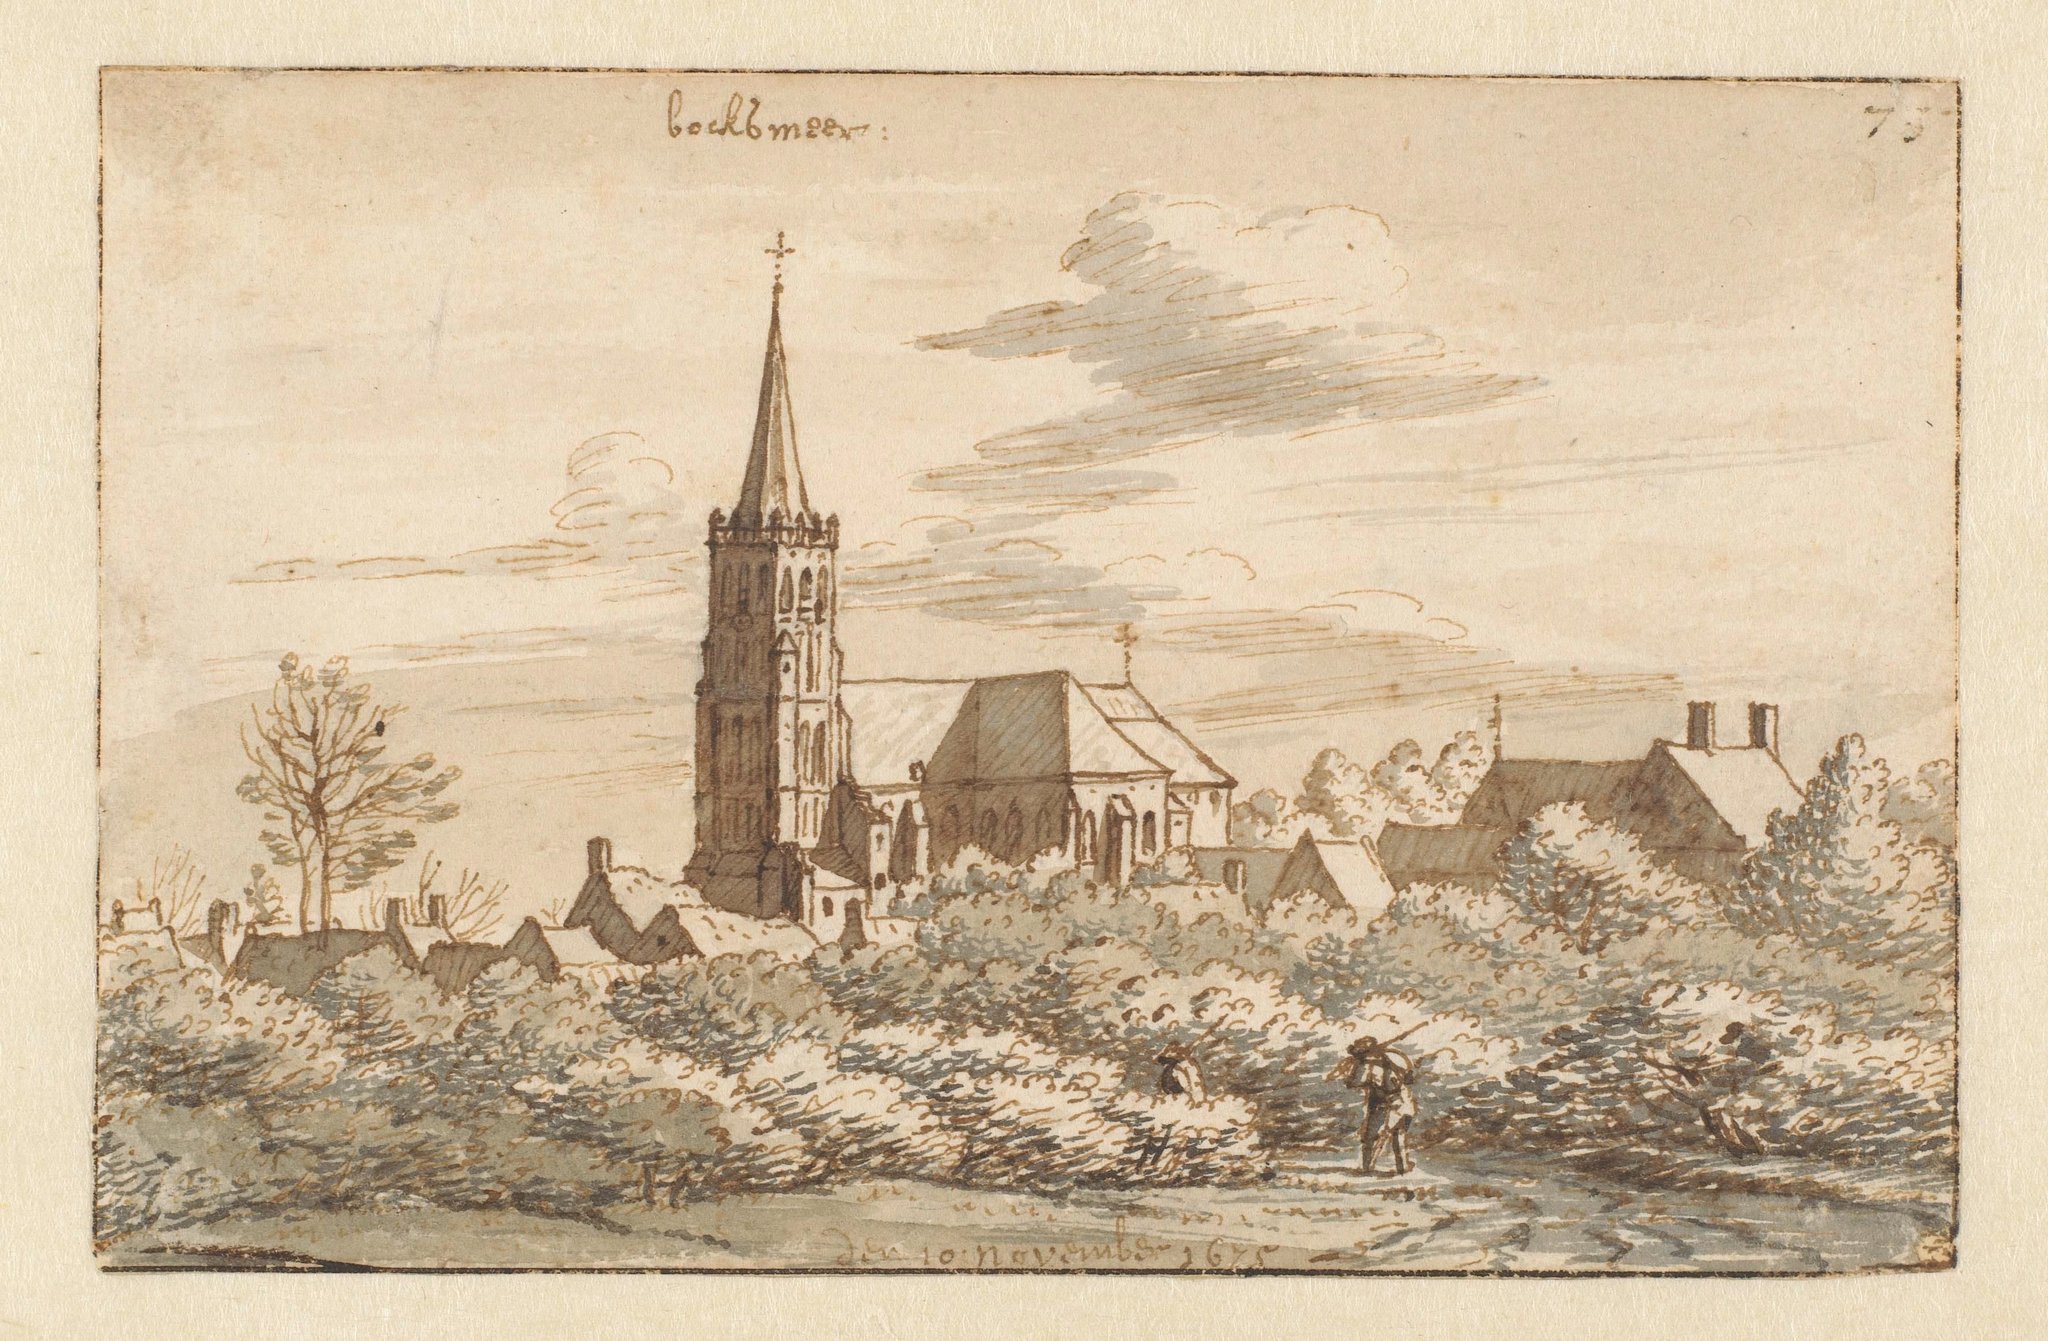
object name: drawing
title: View of Boxmeer, Noord-Brabant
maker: barend klotz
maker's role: draughtsman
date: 1675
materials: ink, paper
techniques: brush, pen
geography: boxmeer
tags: prospect of village, silhouette of village, church (exterior), boxmeer